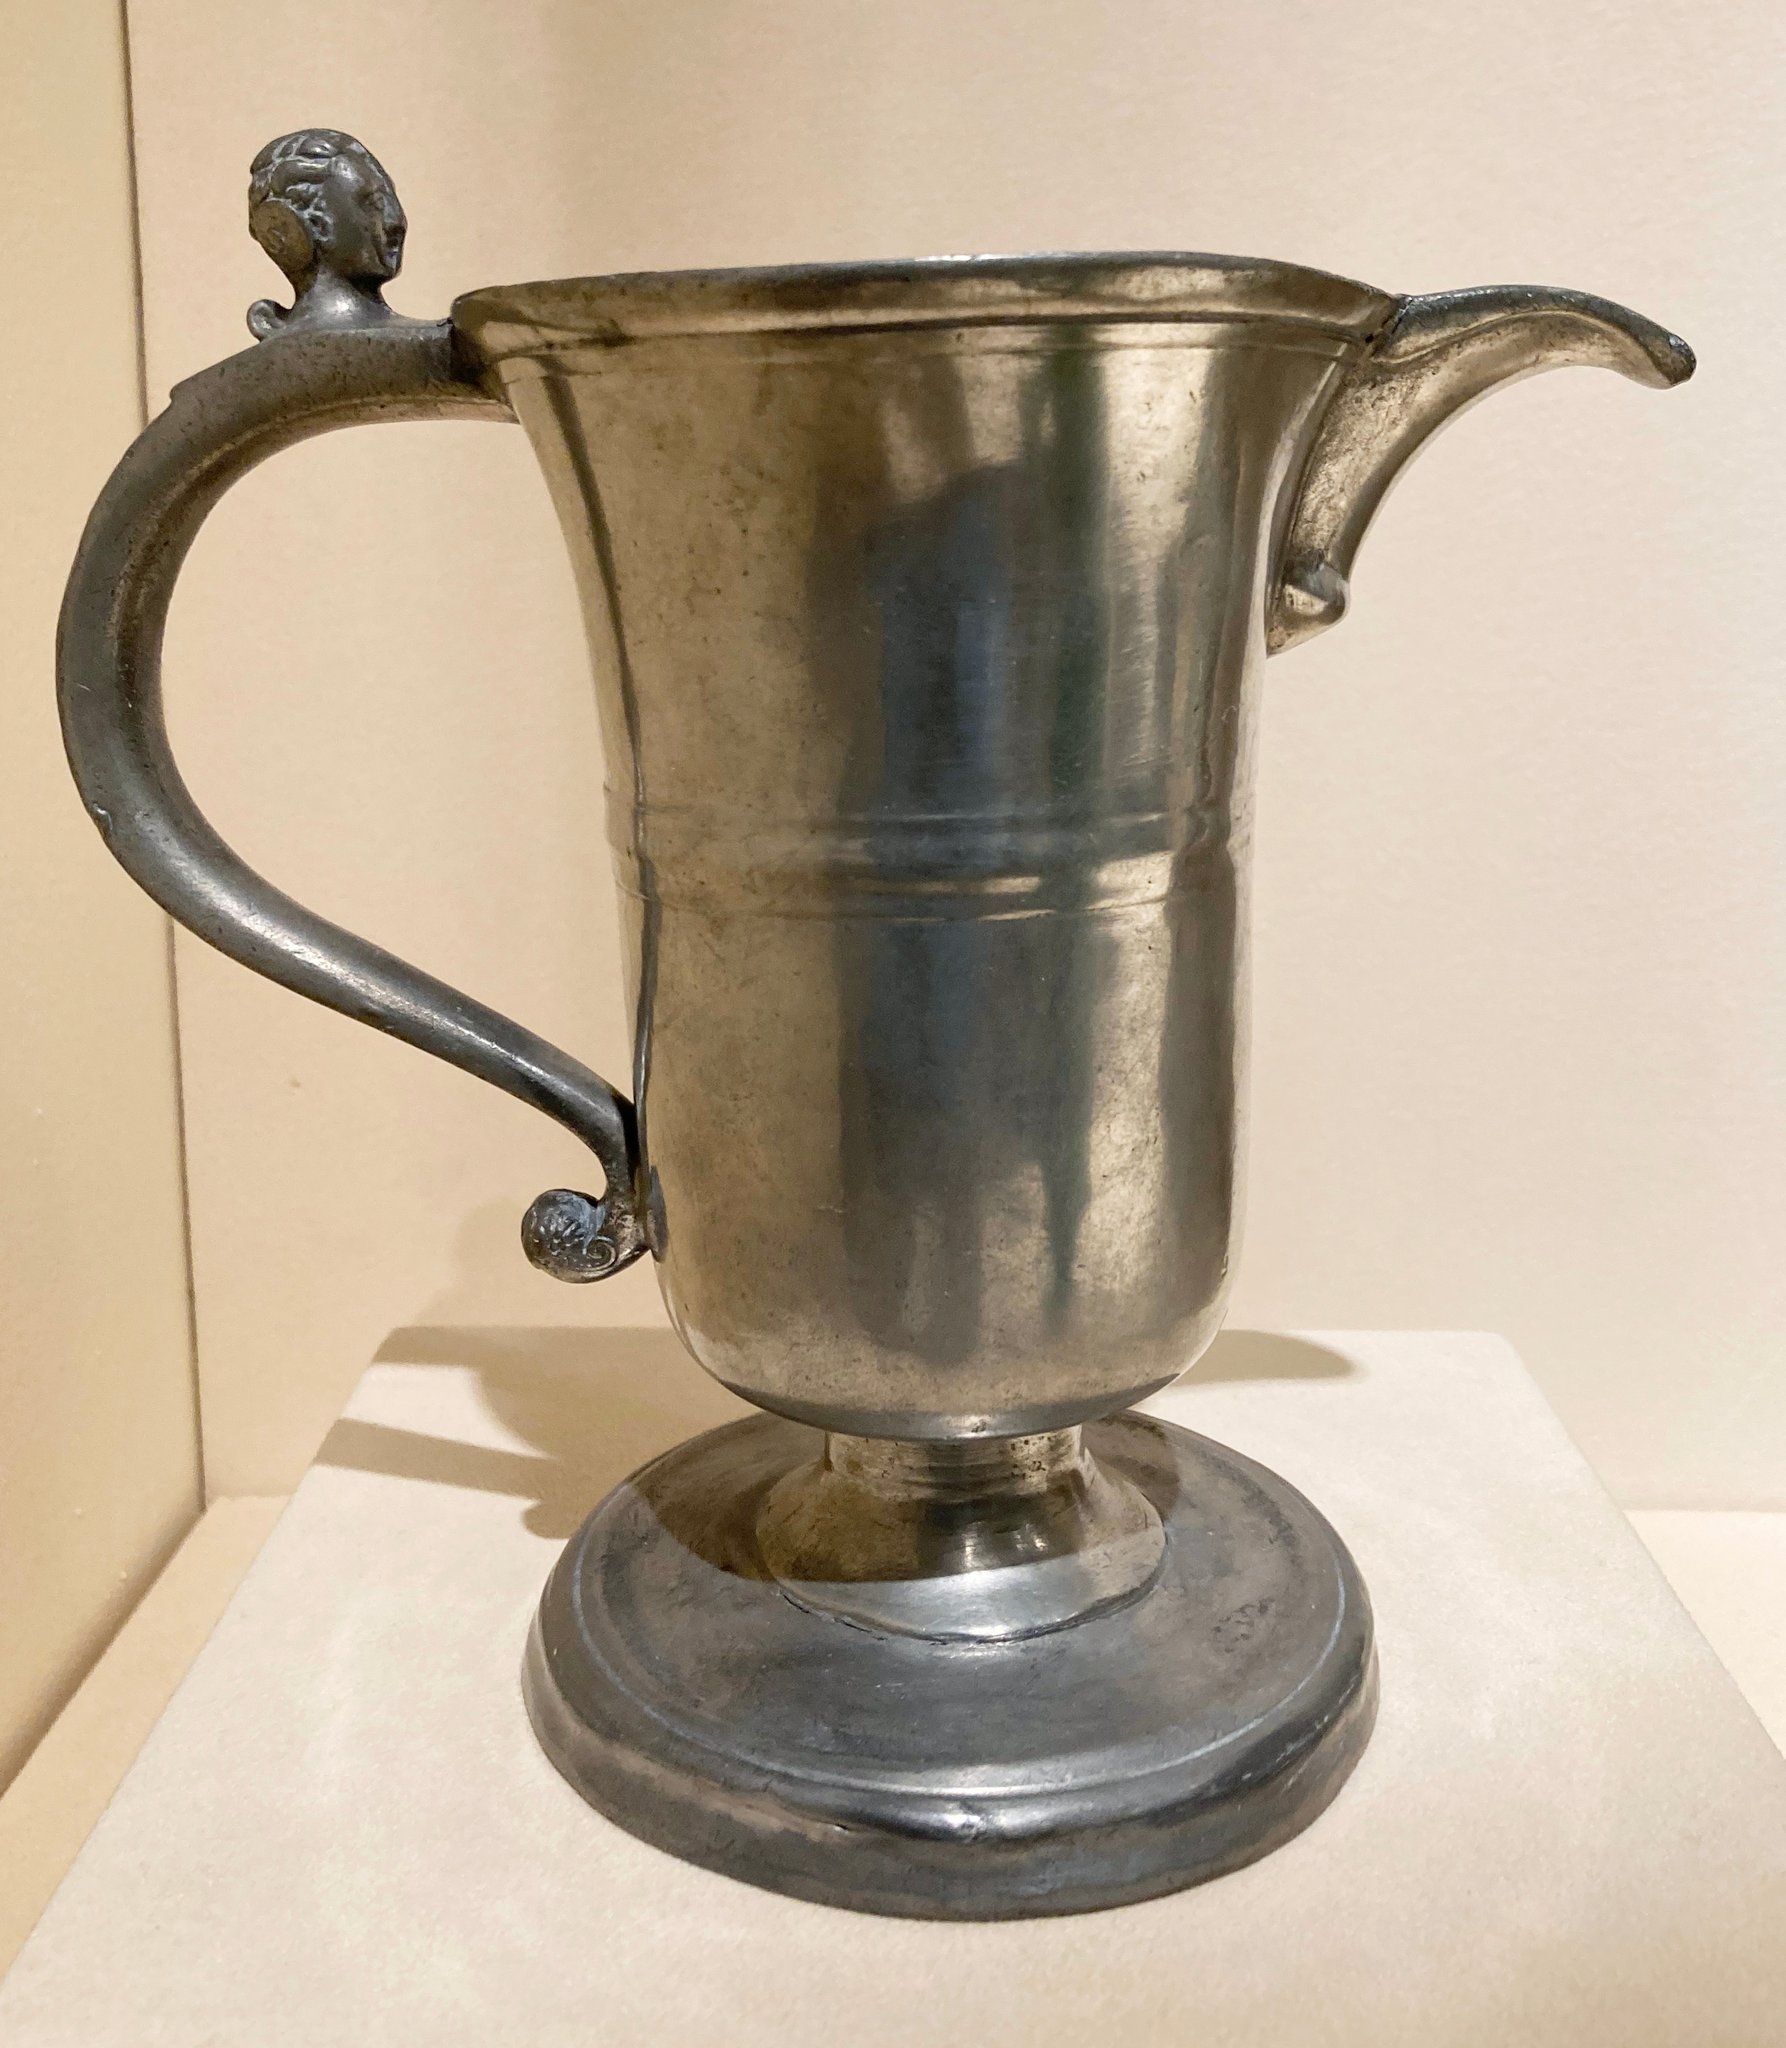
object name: ewer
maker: jean gorges i morel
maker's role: maker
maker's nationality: french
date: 1701-1733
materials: pewter